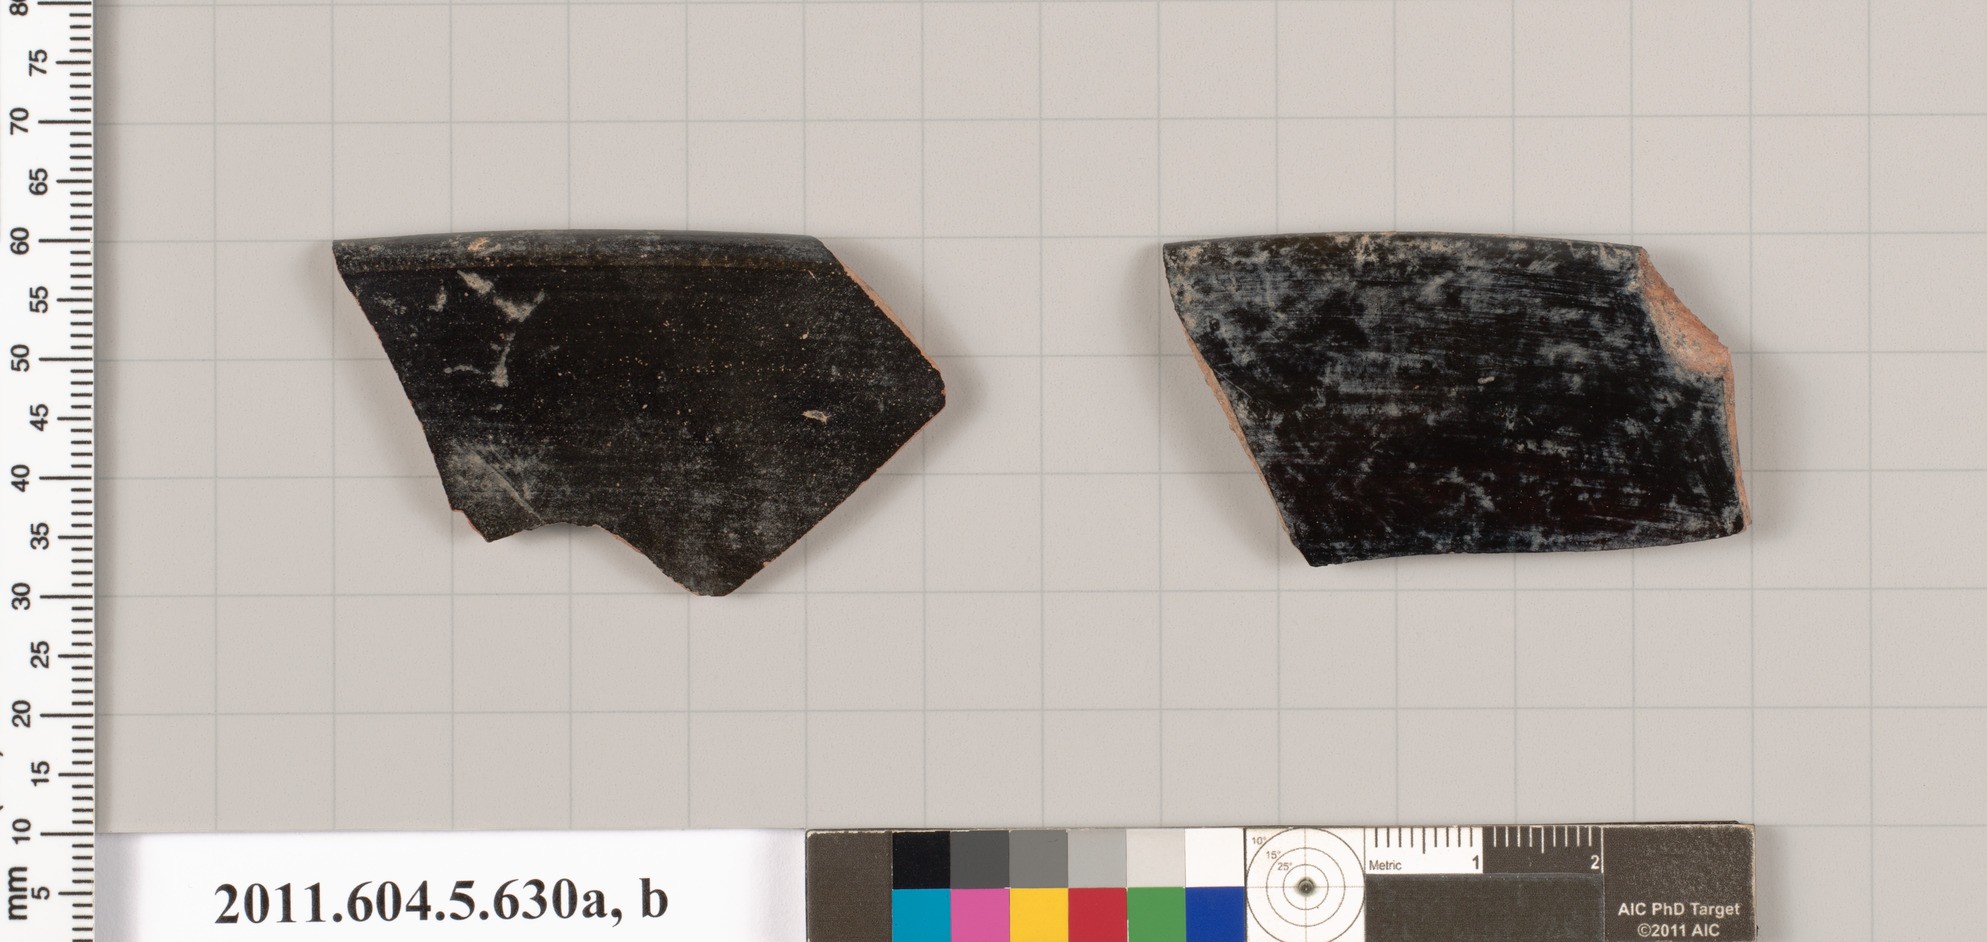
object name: kylix fragment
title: Terracotta rim fragments of kylikes (drinking cups)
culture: greek, attic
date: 600-401 BCE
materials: terracotta